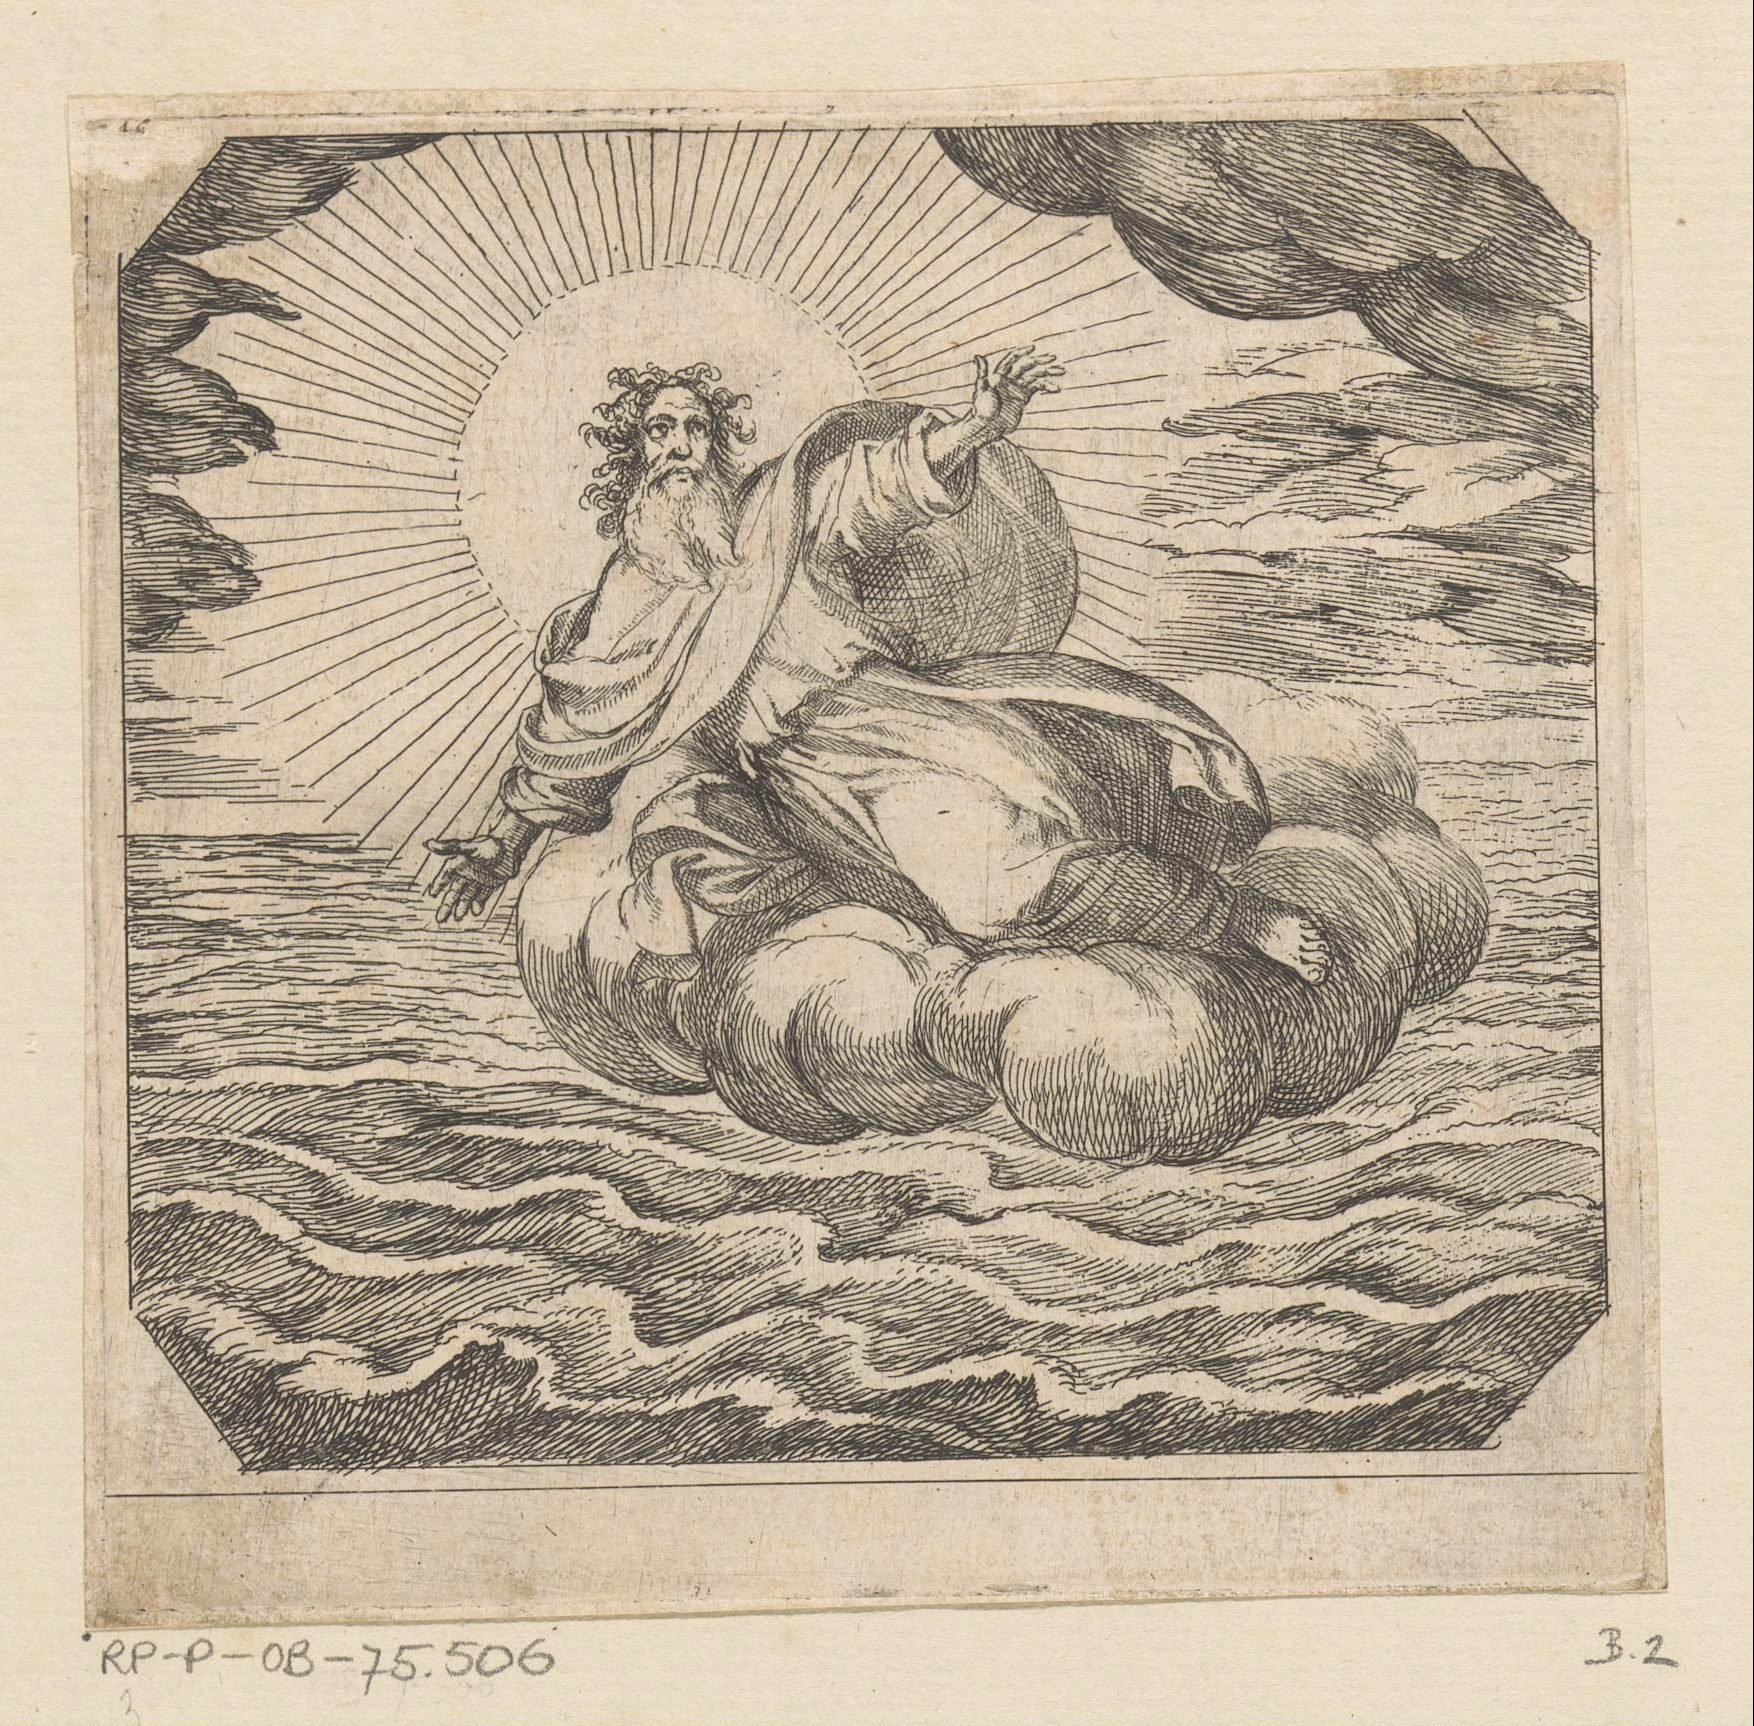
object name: print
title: God schept hemel en aarde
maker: antonio tempesta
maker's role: draughtsman, painter, print maker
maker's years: 1555-1630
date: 1565-1630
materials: paper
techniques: etching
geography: rome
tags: division of light and darkness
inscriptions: collector's mark: Lugt 240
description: Deze prent maakt deel uit van een serie van twaalf prenten van de schepping. De prenten zijn deels naar ontwerpen van Rafaël voor de Loggia van Rafaël in het Vaticaan, en deels naar prenten door Nicolaes de Bruyn naar ontwerpen van Maerten de Vos (zie: Holl. Dutch. vol. 45 nr. 1-10).